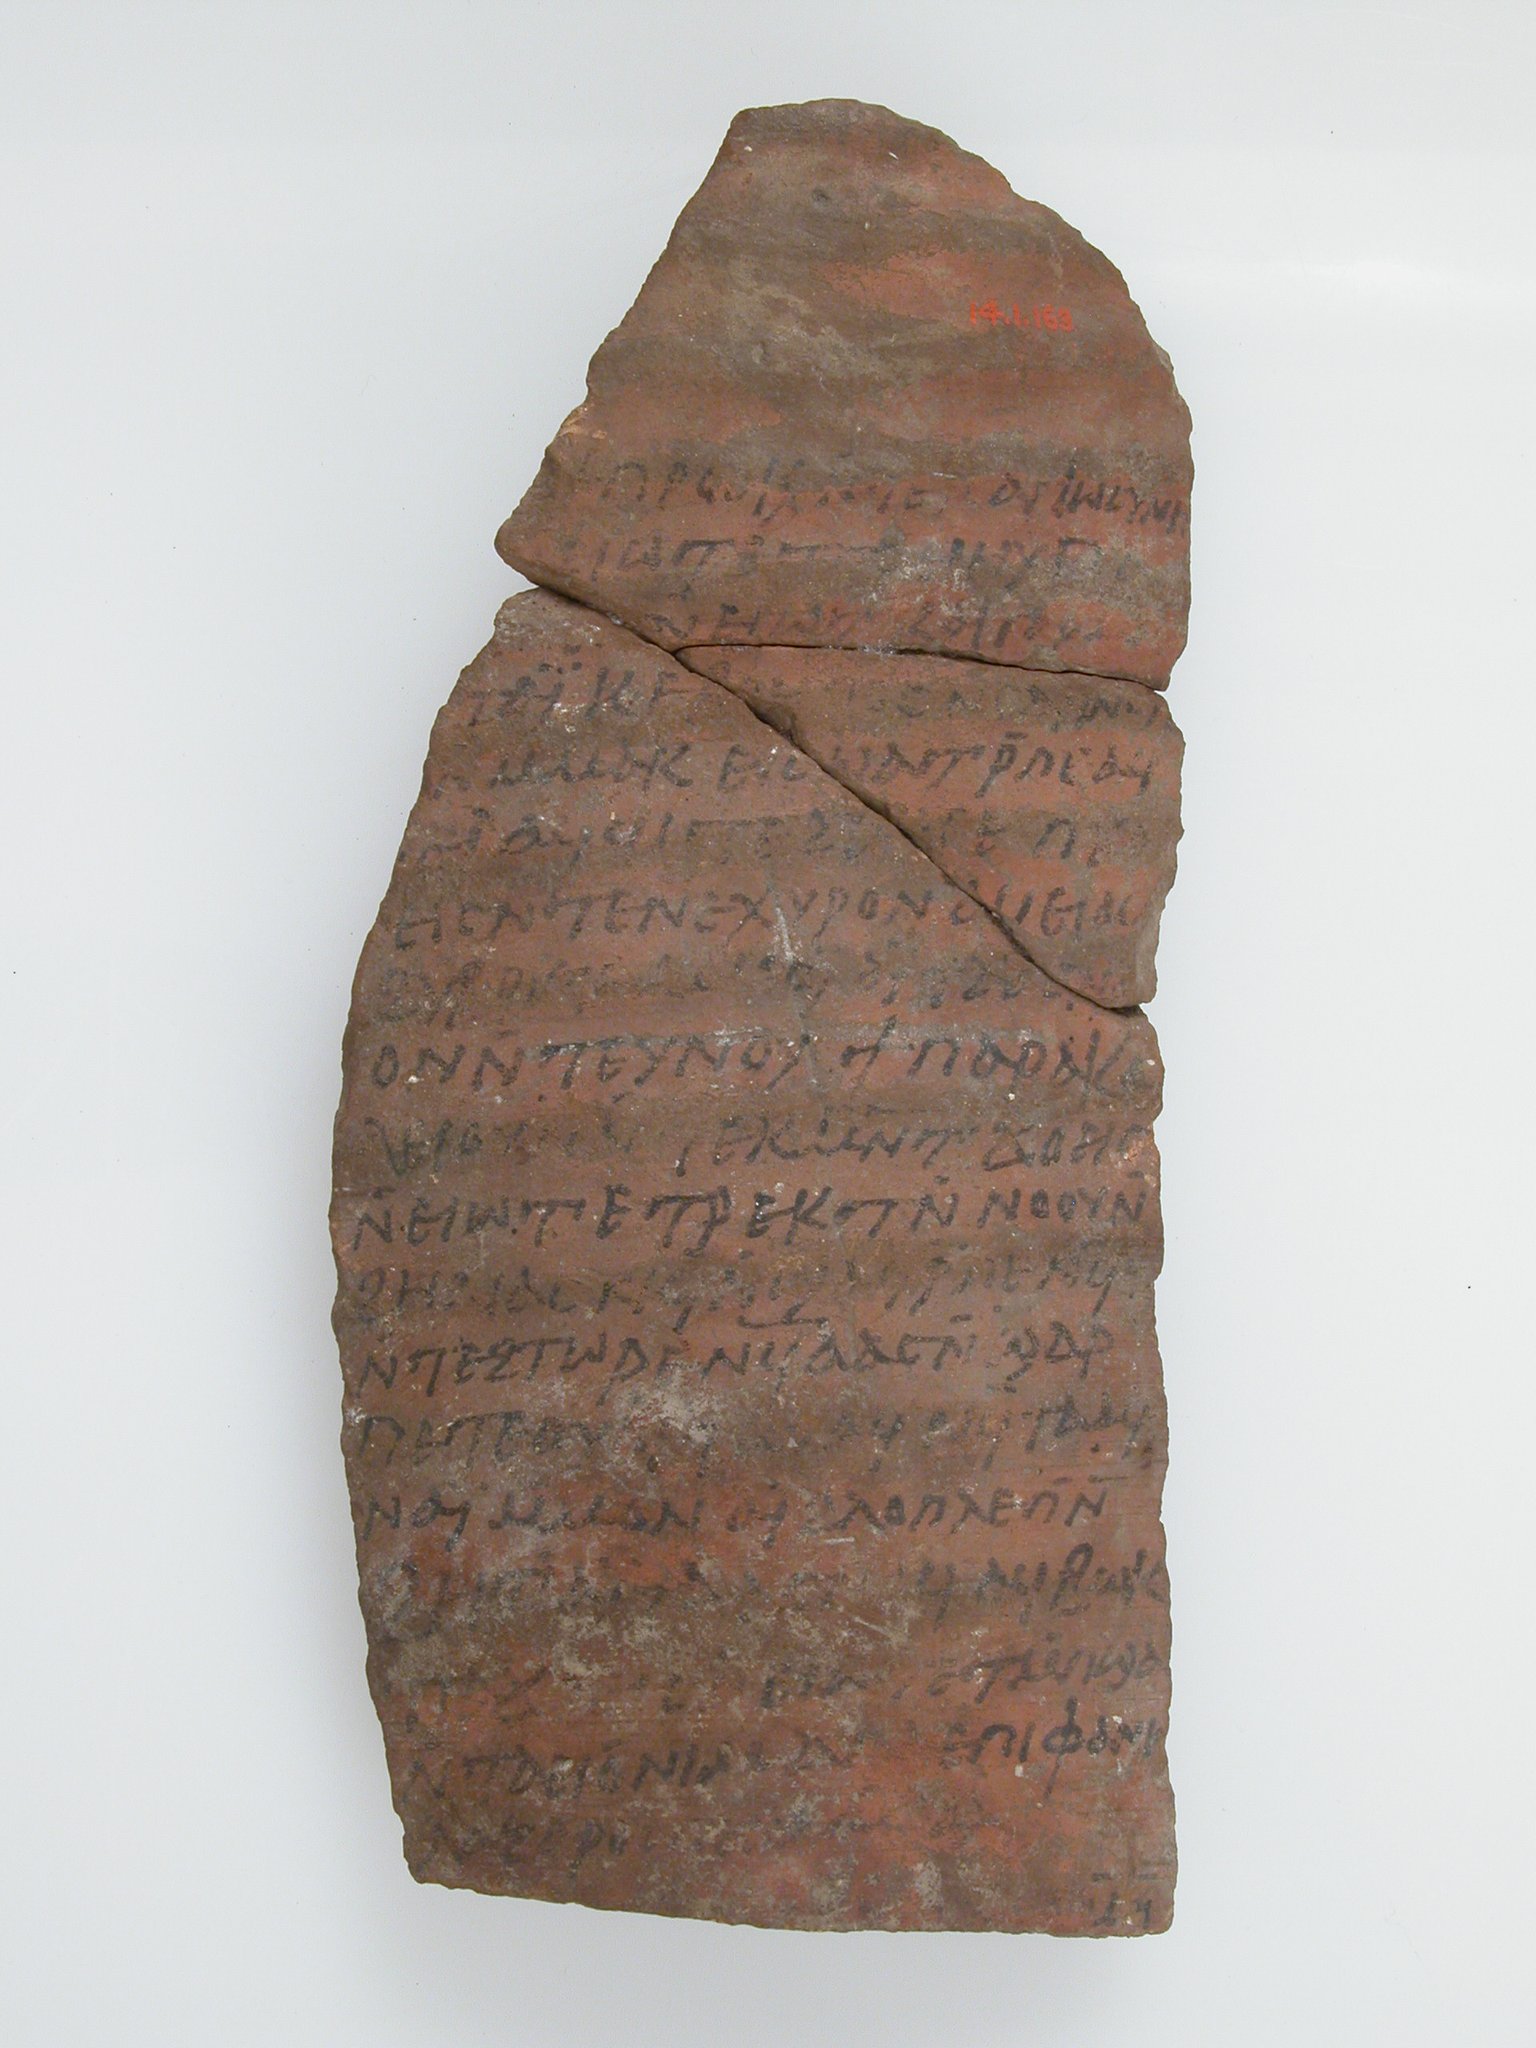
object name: ostrakon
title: Ostrakon with a Letter from Lazarius to Epiphanius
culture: coptic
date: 600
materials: ink, pottery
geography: egypt